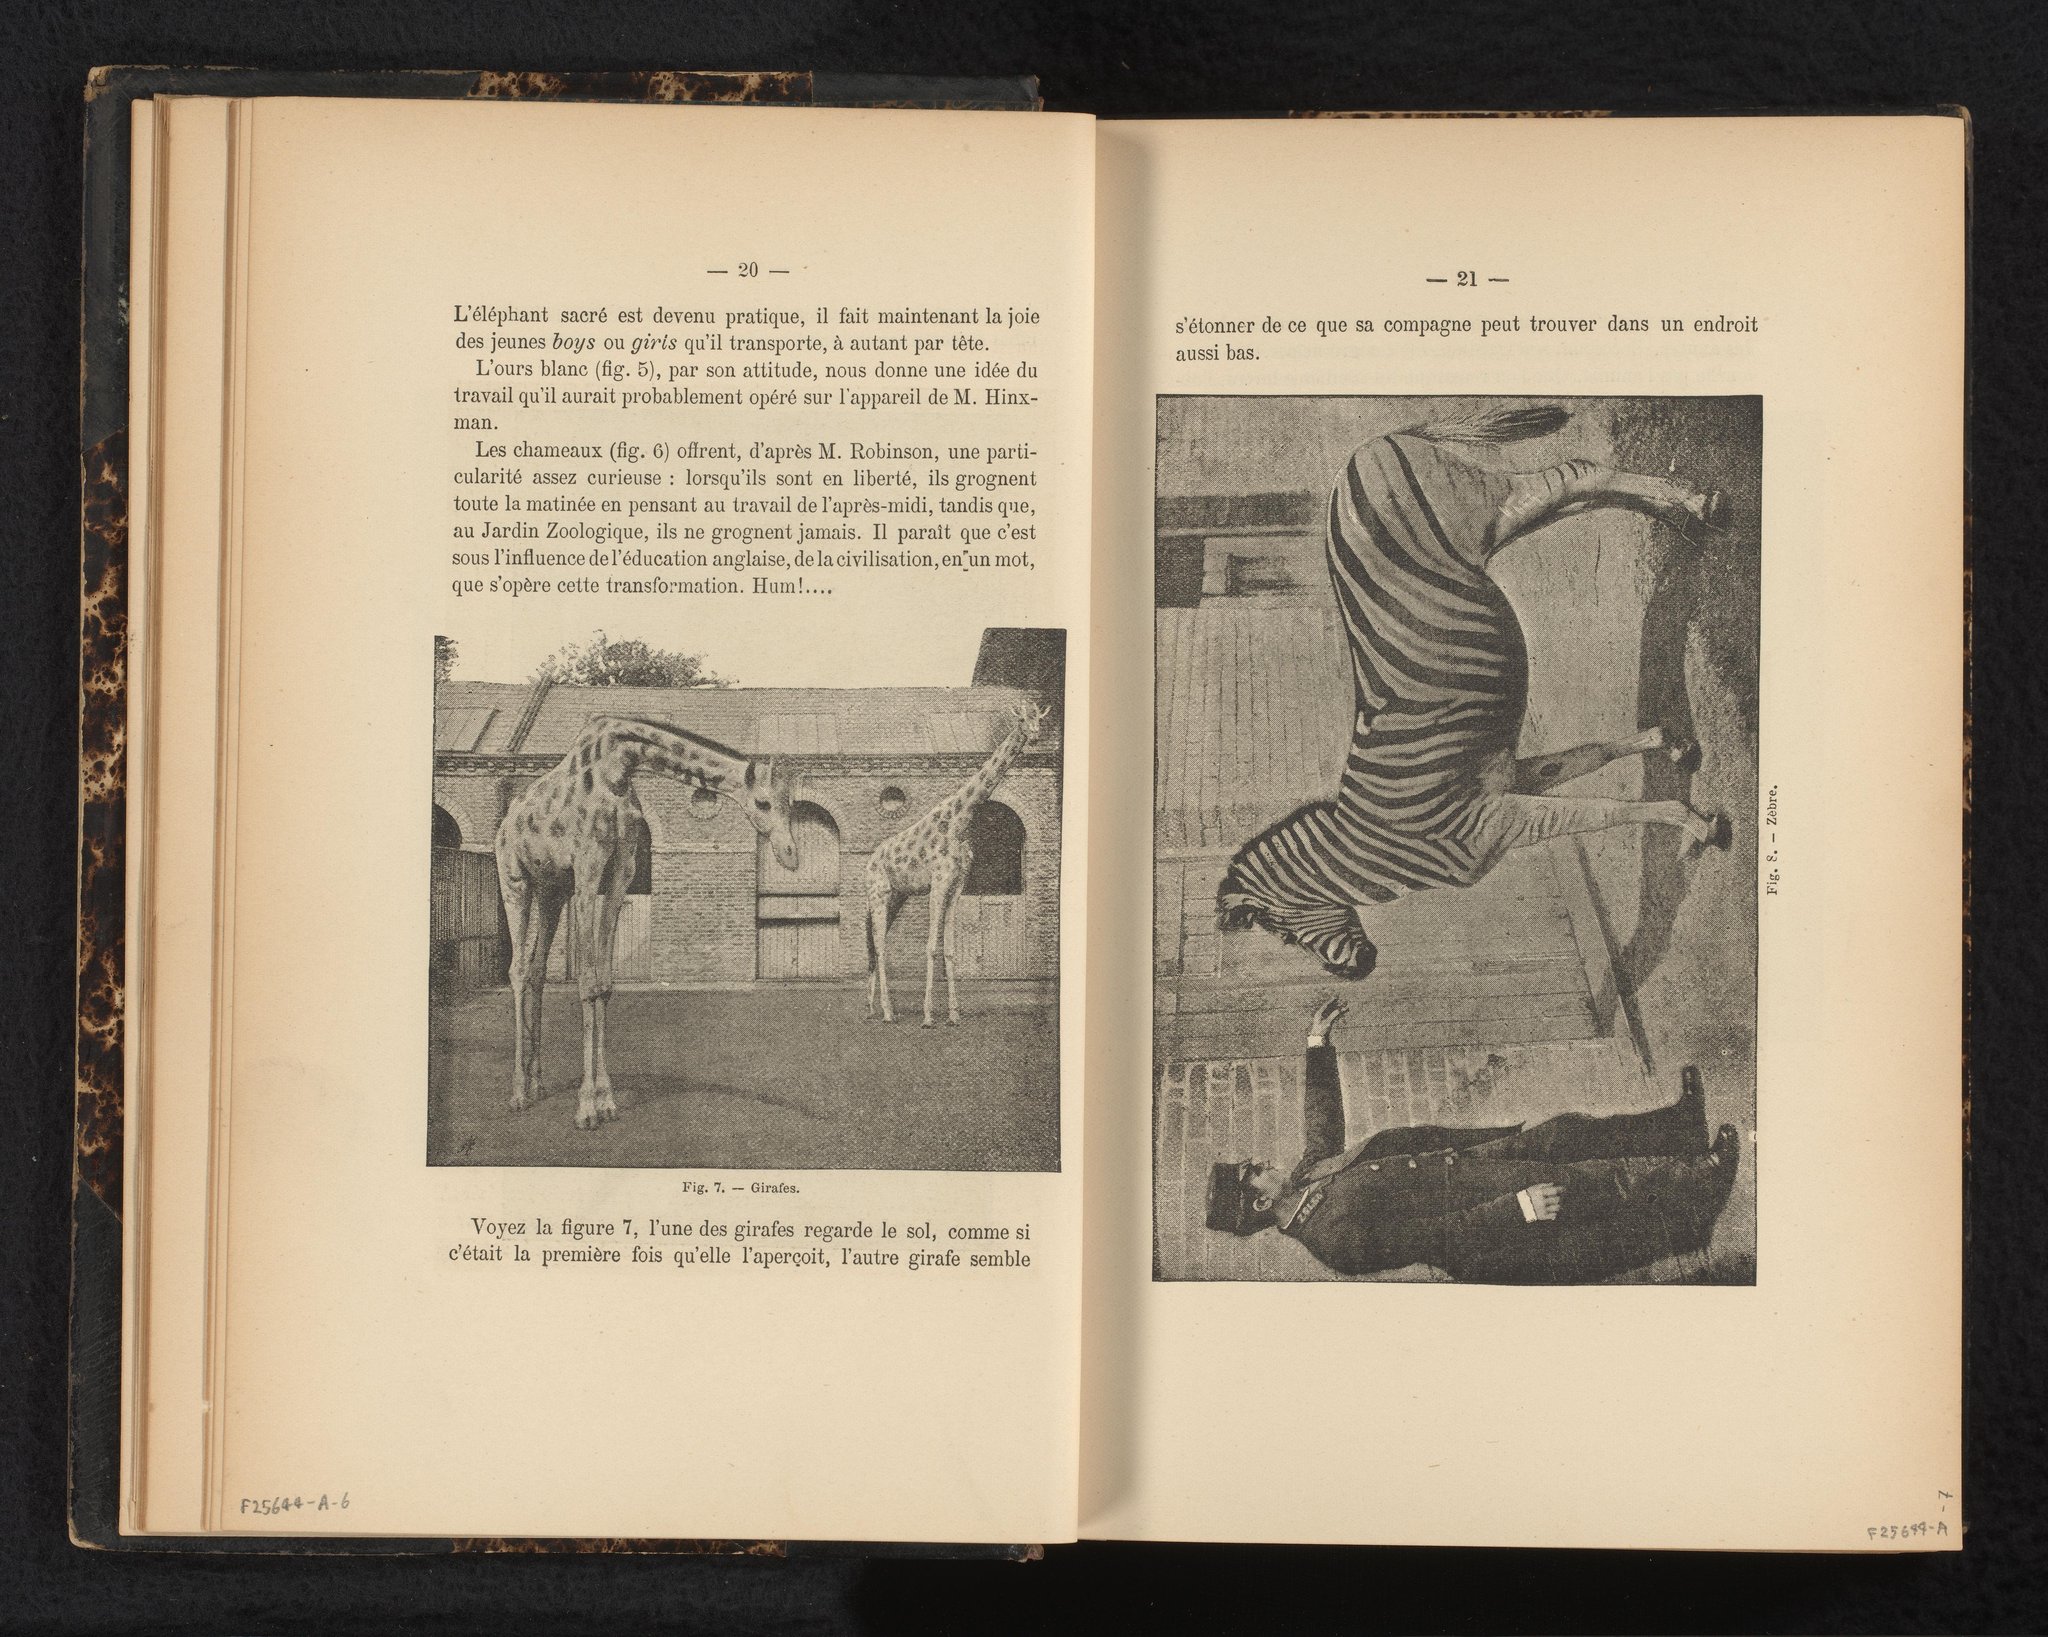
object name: photomechanical print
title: Zebra met verzorger in de London Zoo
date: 1882-1887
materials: paper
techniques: autotype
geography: london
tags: hoofed animals (with name)